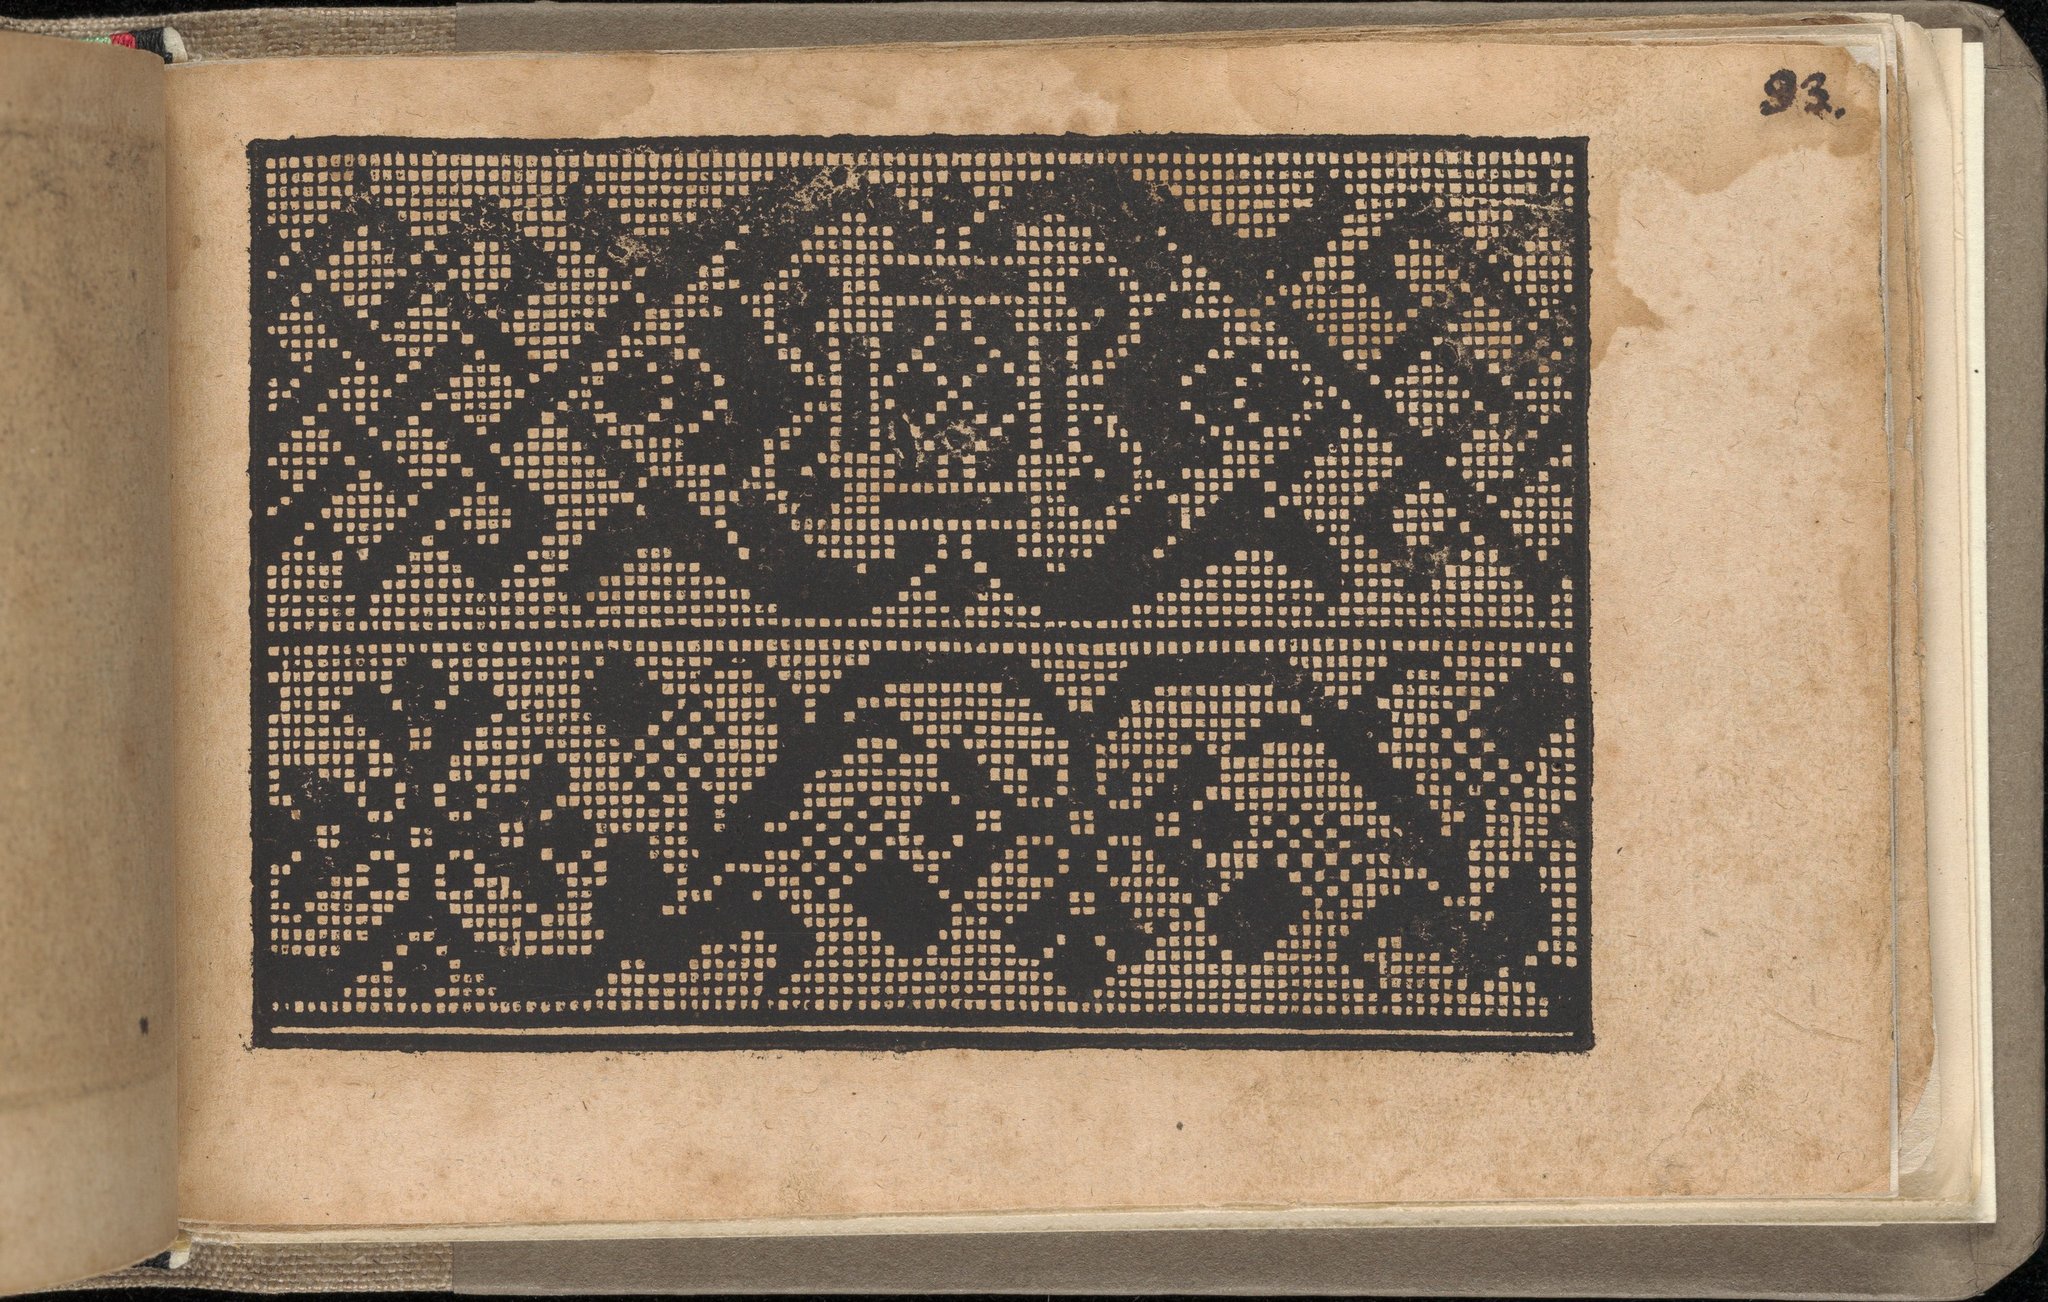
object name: book print ornament architecture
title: Schön newes Modelbuch (Page 93r)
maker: sigismundus latomus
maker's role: publisher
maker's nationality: german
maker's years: 1599-1632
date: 1608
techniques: woodcut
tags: ornament